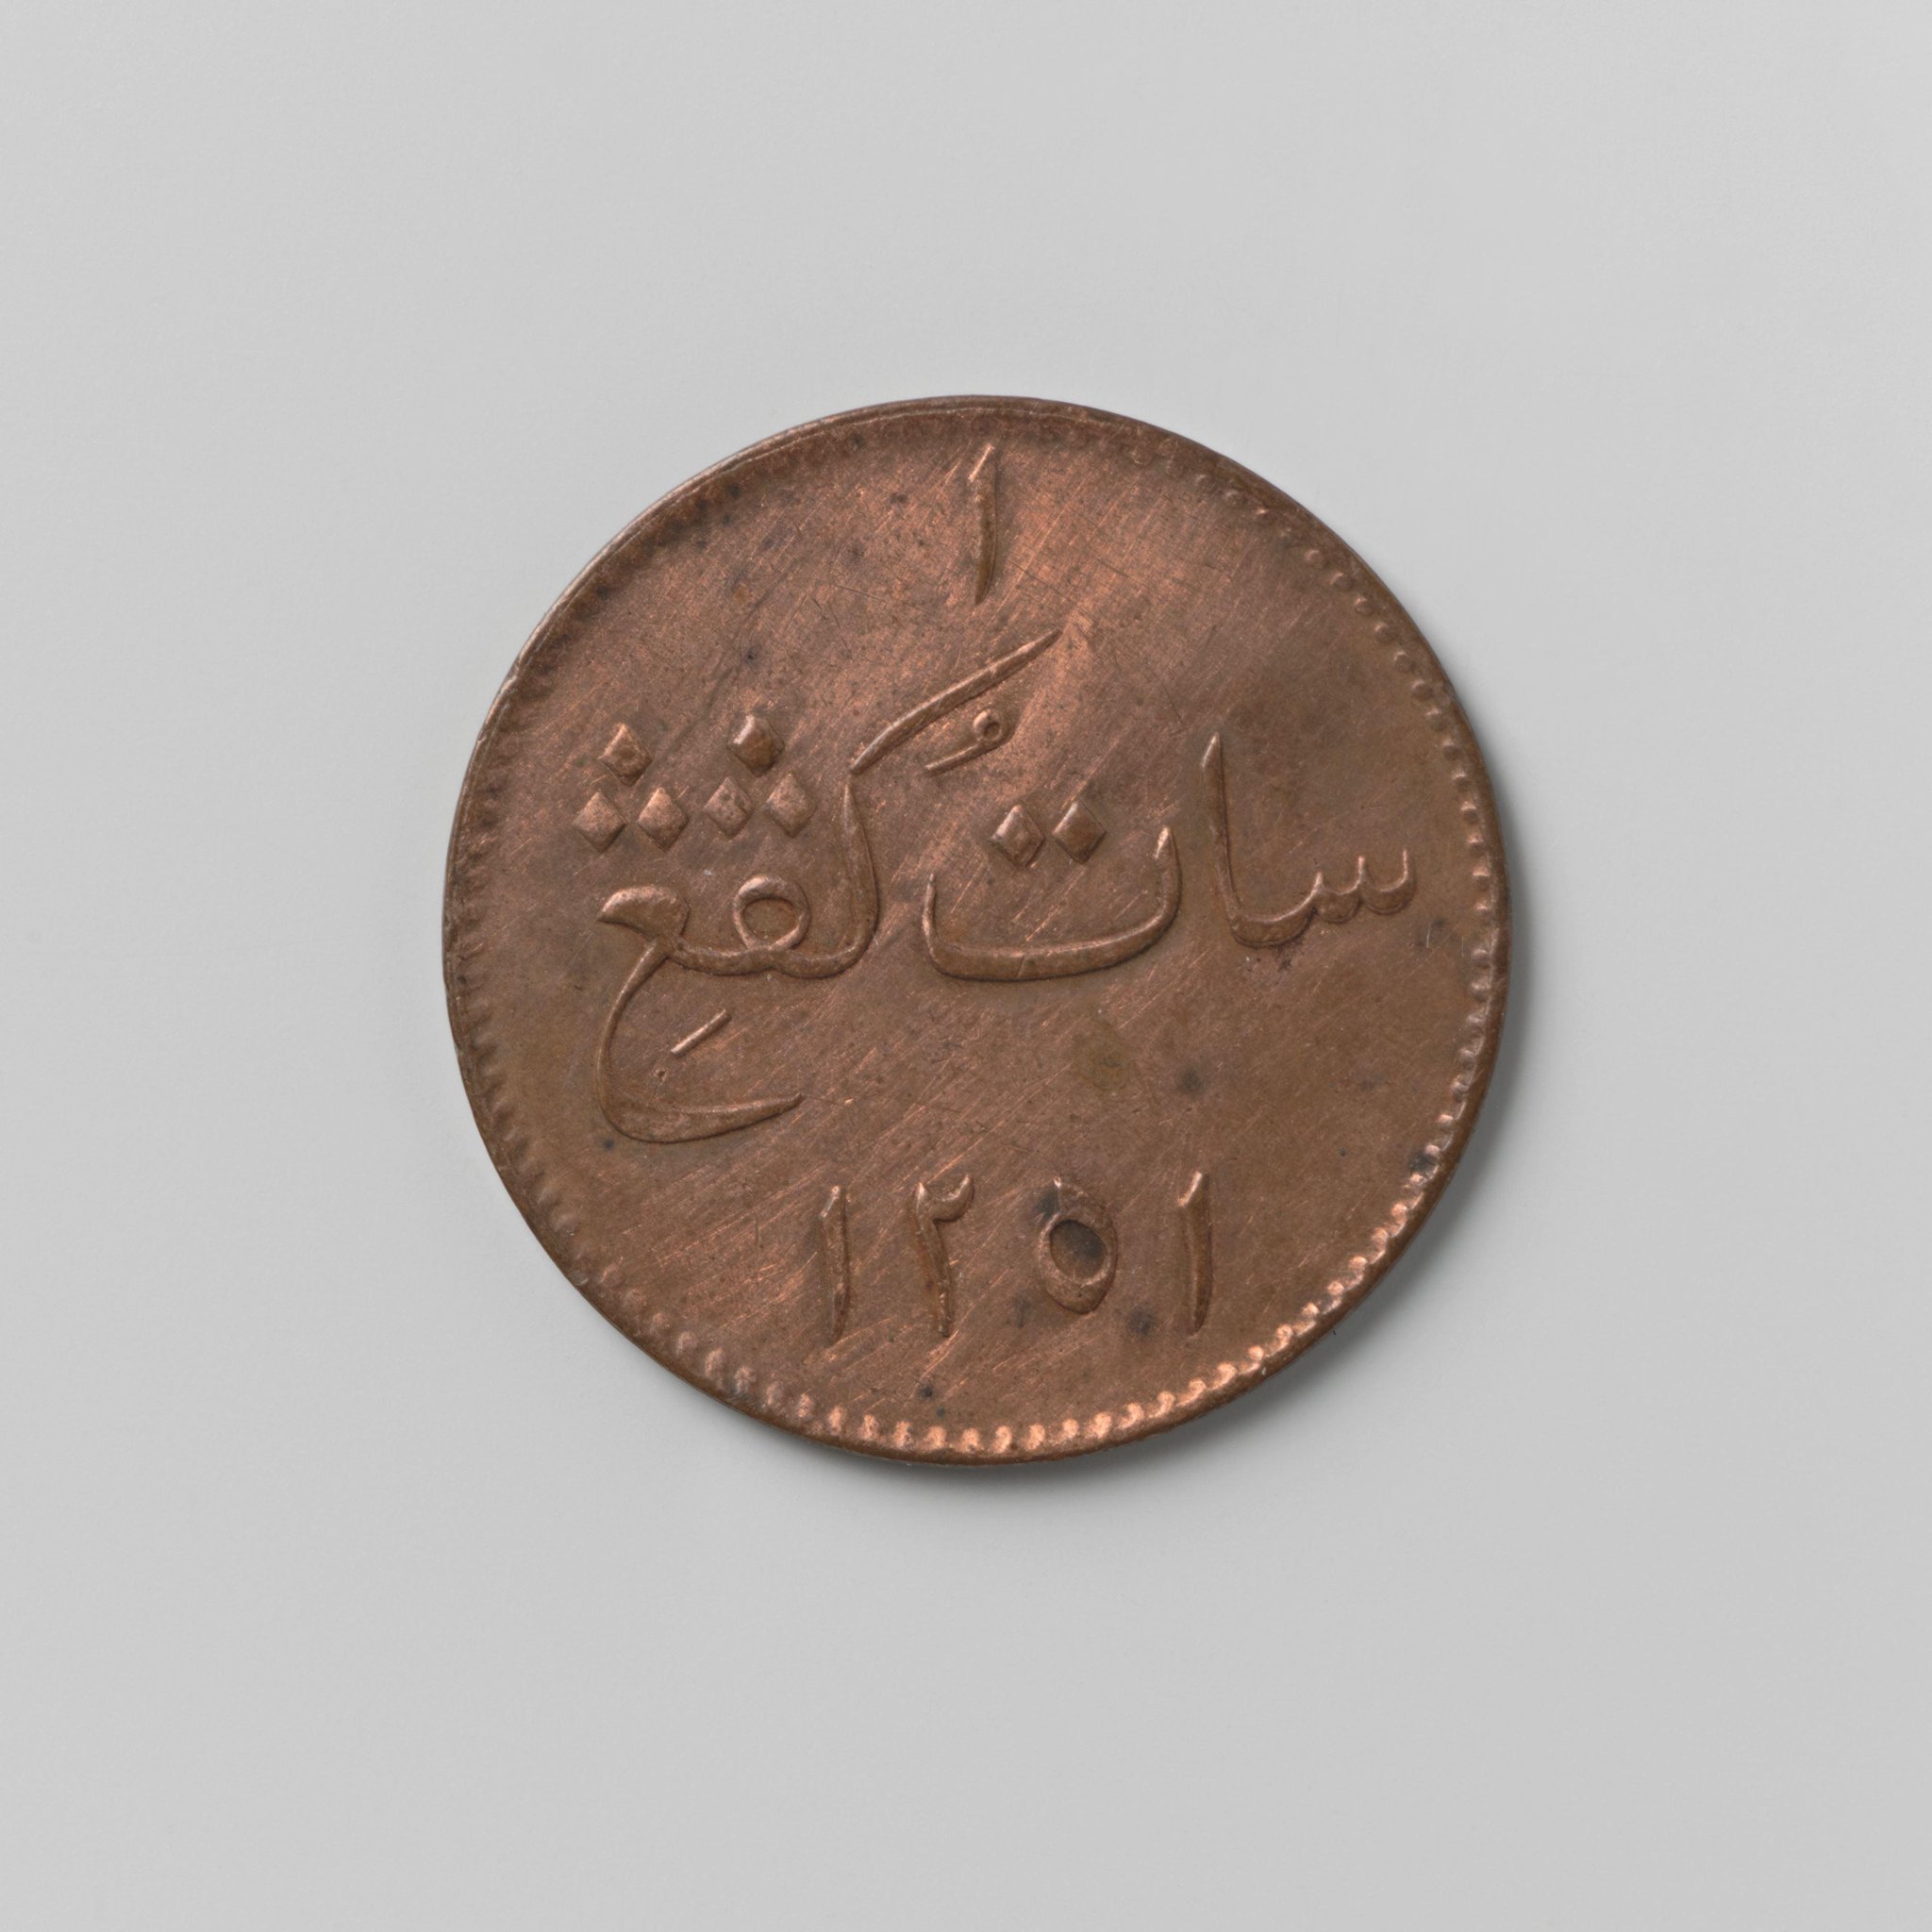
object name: coin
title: Siak op Sumatra, kepeng, 1835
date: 1835-1836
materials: copper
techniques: striking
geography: birmingham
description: Koperen munt. Particuliere munt. Voorzijde: tweeregelig opschrift: aanduiding in het Maleis in Arabische lettertekens: Negri Siak. Keerzijde: eenregelig Maleis opschrift in Arabische lettertekens: een kepeng, waarboven waarde-aanduiding 1 en waaronder het jaartal 1251 in Islamitische tijdsrekening. Gladde rand.